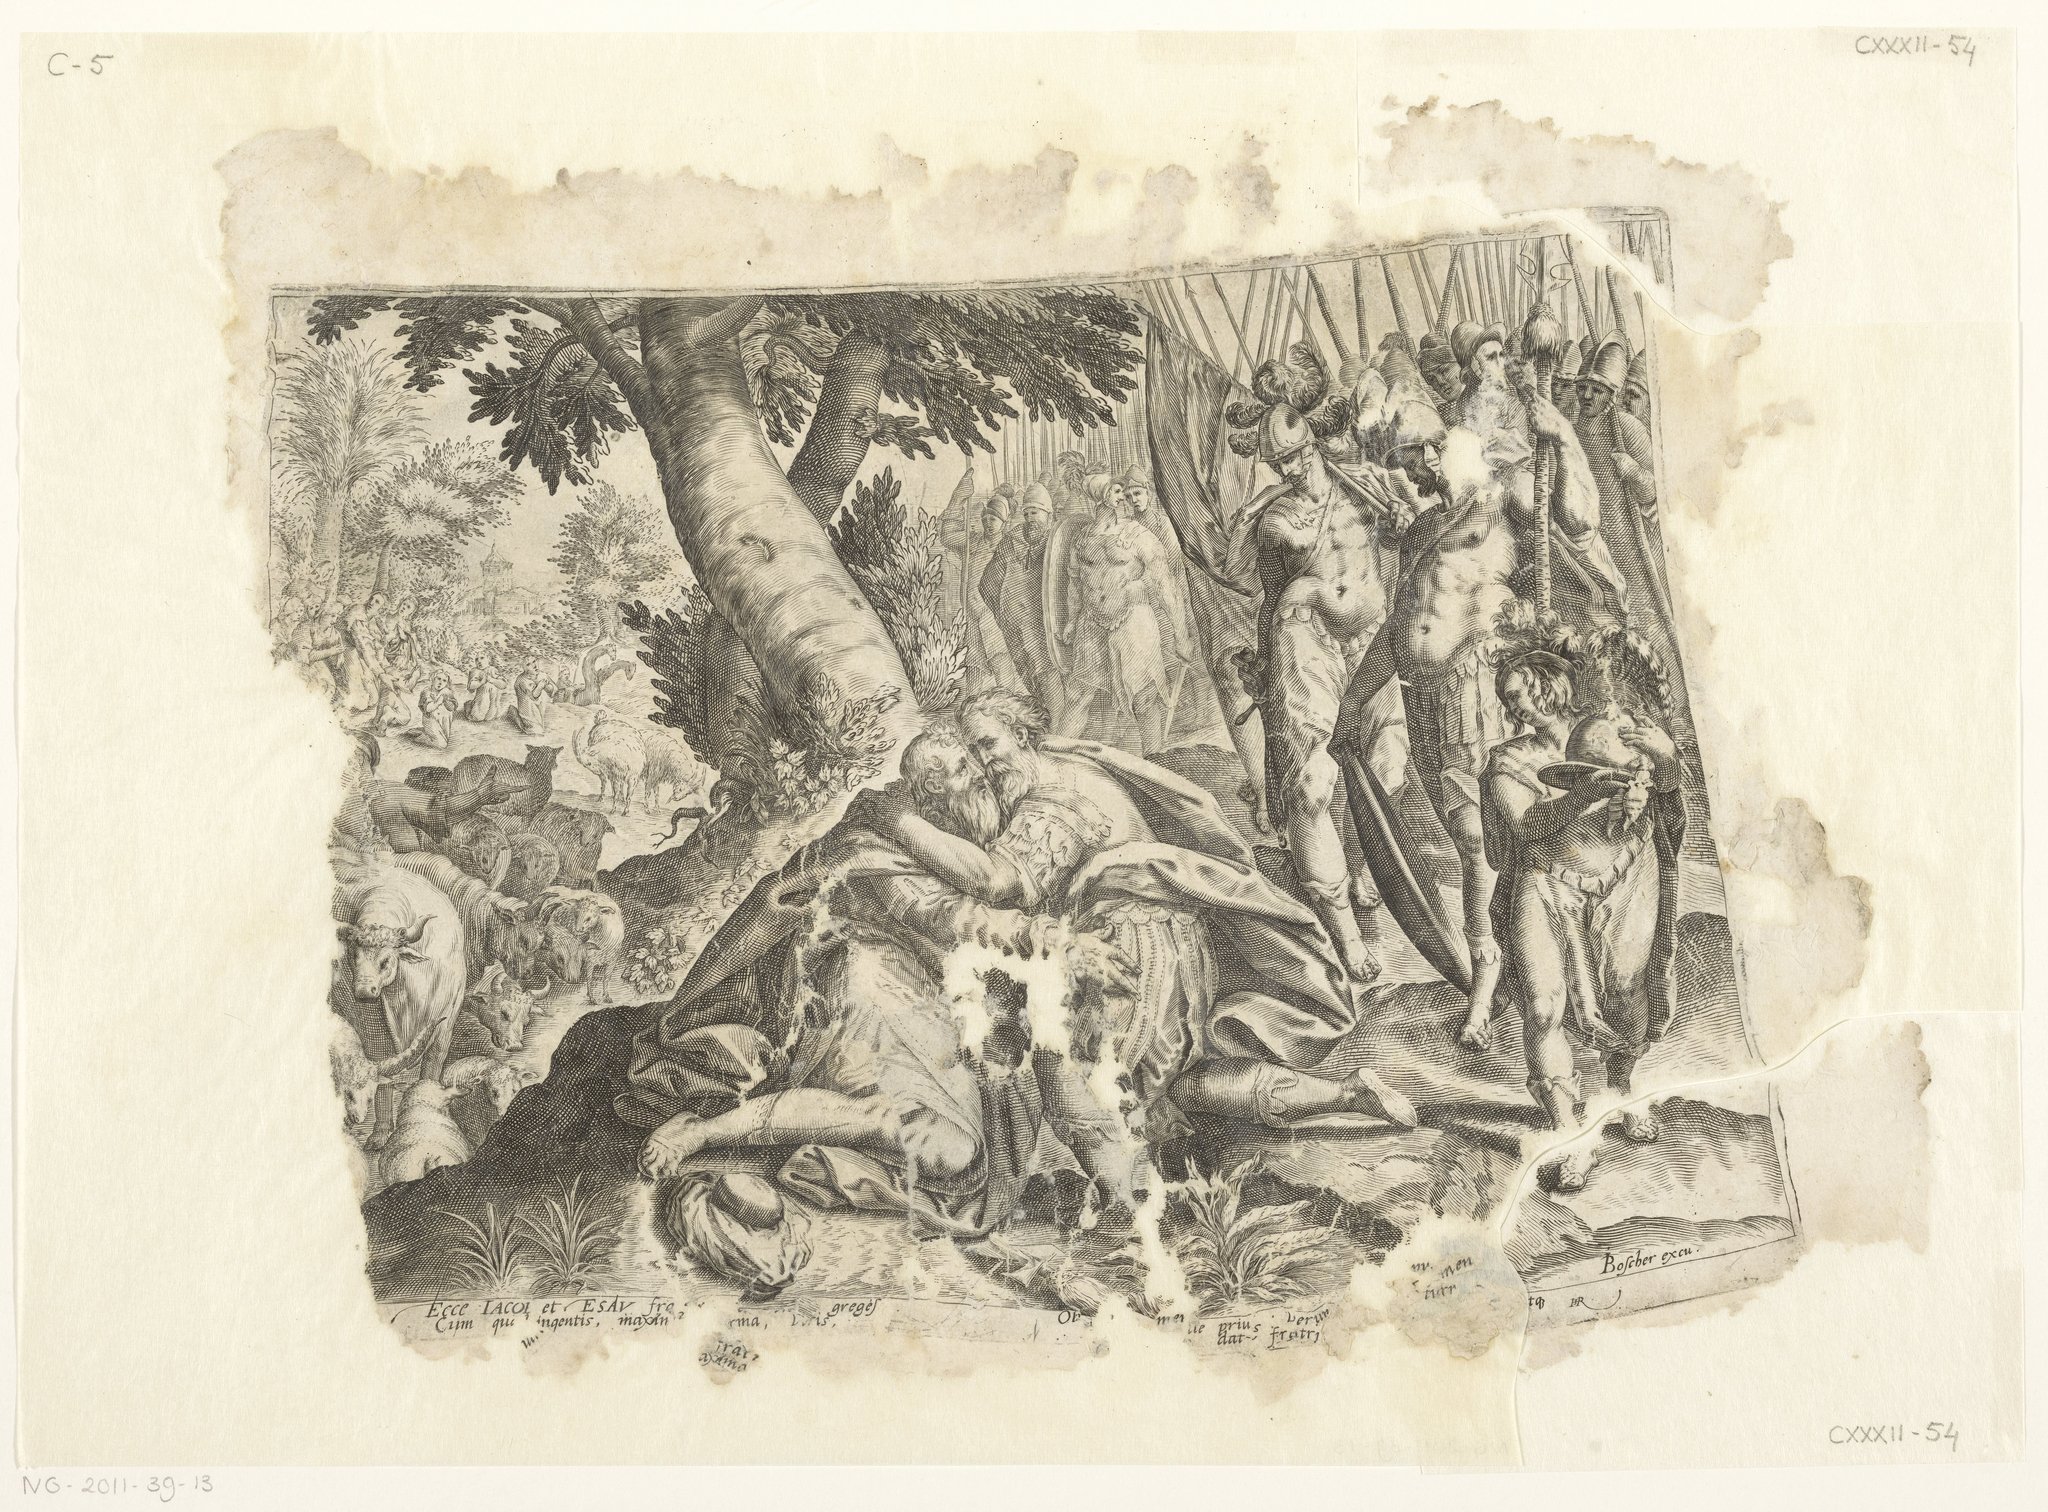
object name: print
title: Verzoening van Jakob en Esau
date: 1580-1596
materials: paper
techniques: engraving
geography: northern netherlands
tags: the meeting between esau and jacob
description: Tot dusverre was deze prent alleen bekend in een latere editie met het adres van C.J. Visscher in het door hem uitgegeven Theatrum Biblicum uit 1643, zie RP-P-1976-30-39. De prenten in de Nova Zembla collectie zijn tijdens een expeditie van Willem Barendsz en Jacob van Heemskerk in 1596-1597 noodgedwongen in het winterkamp, het ‘Behouden Huis’, op het eiland achtergelaten. De prenten waren in één of meerdere stapels als handelswaar meegenomen vanuit Amsterdam. Bijna drie eeuwen later, in 1871, keerde de Noor Elling Carlsen terug naar Nova Zembla en vond daar de restanten van het ‘Behouden Huis, inclusief een groot deel van de inventaris. Een deel van de prenten, in de vorm van aaneengekoekte kluiten, werd toen ook teruggevonden. De papierkluiten waren soms op meerdere plekken gebroken. Tussen 1975-1979 zijn de prenten van elkaar gescheiden. Dit leverde in totaal ca. 1000 fragmenten van ca. 400 afdrukken van ca. 150 verschillende prenten op. Voor zover mogelijk zijn de fragmenten samengevoegd en zijn de prenten gereconstrueerd.